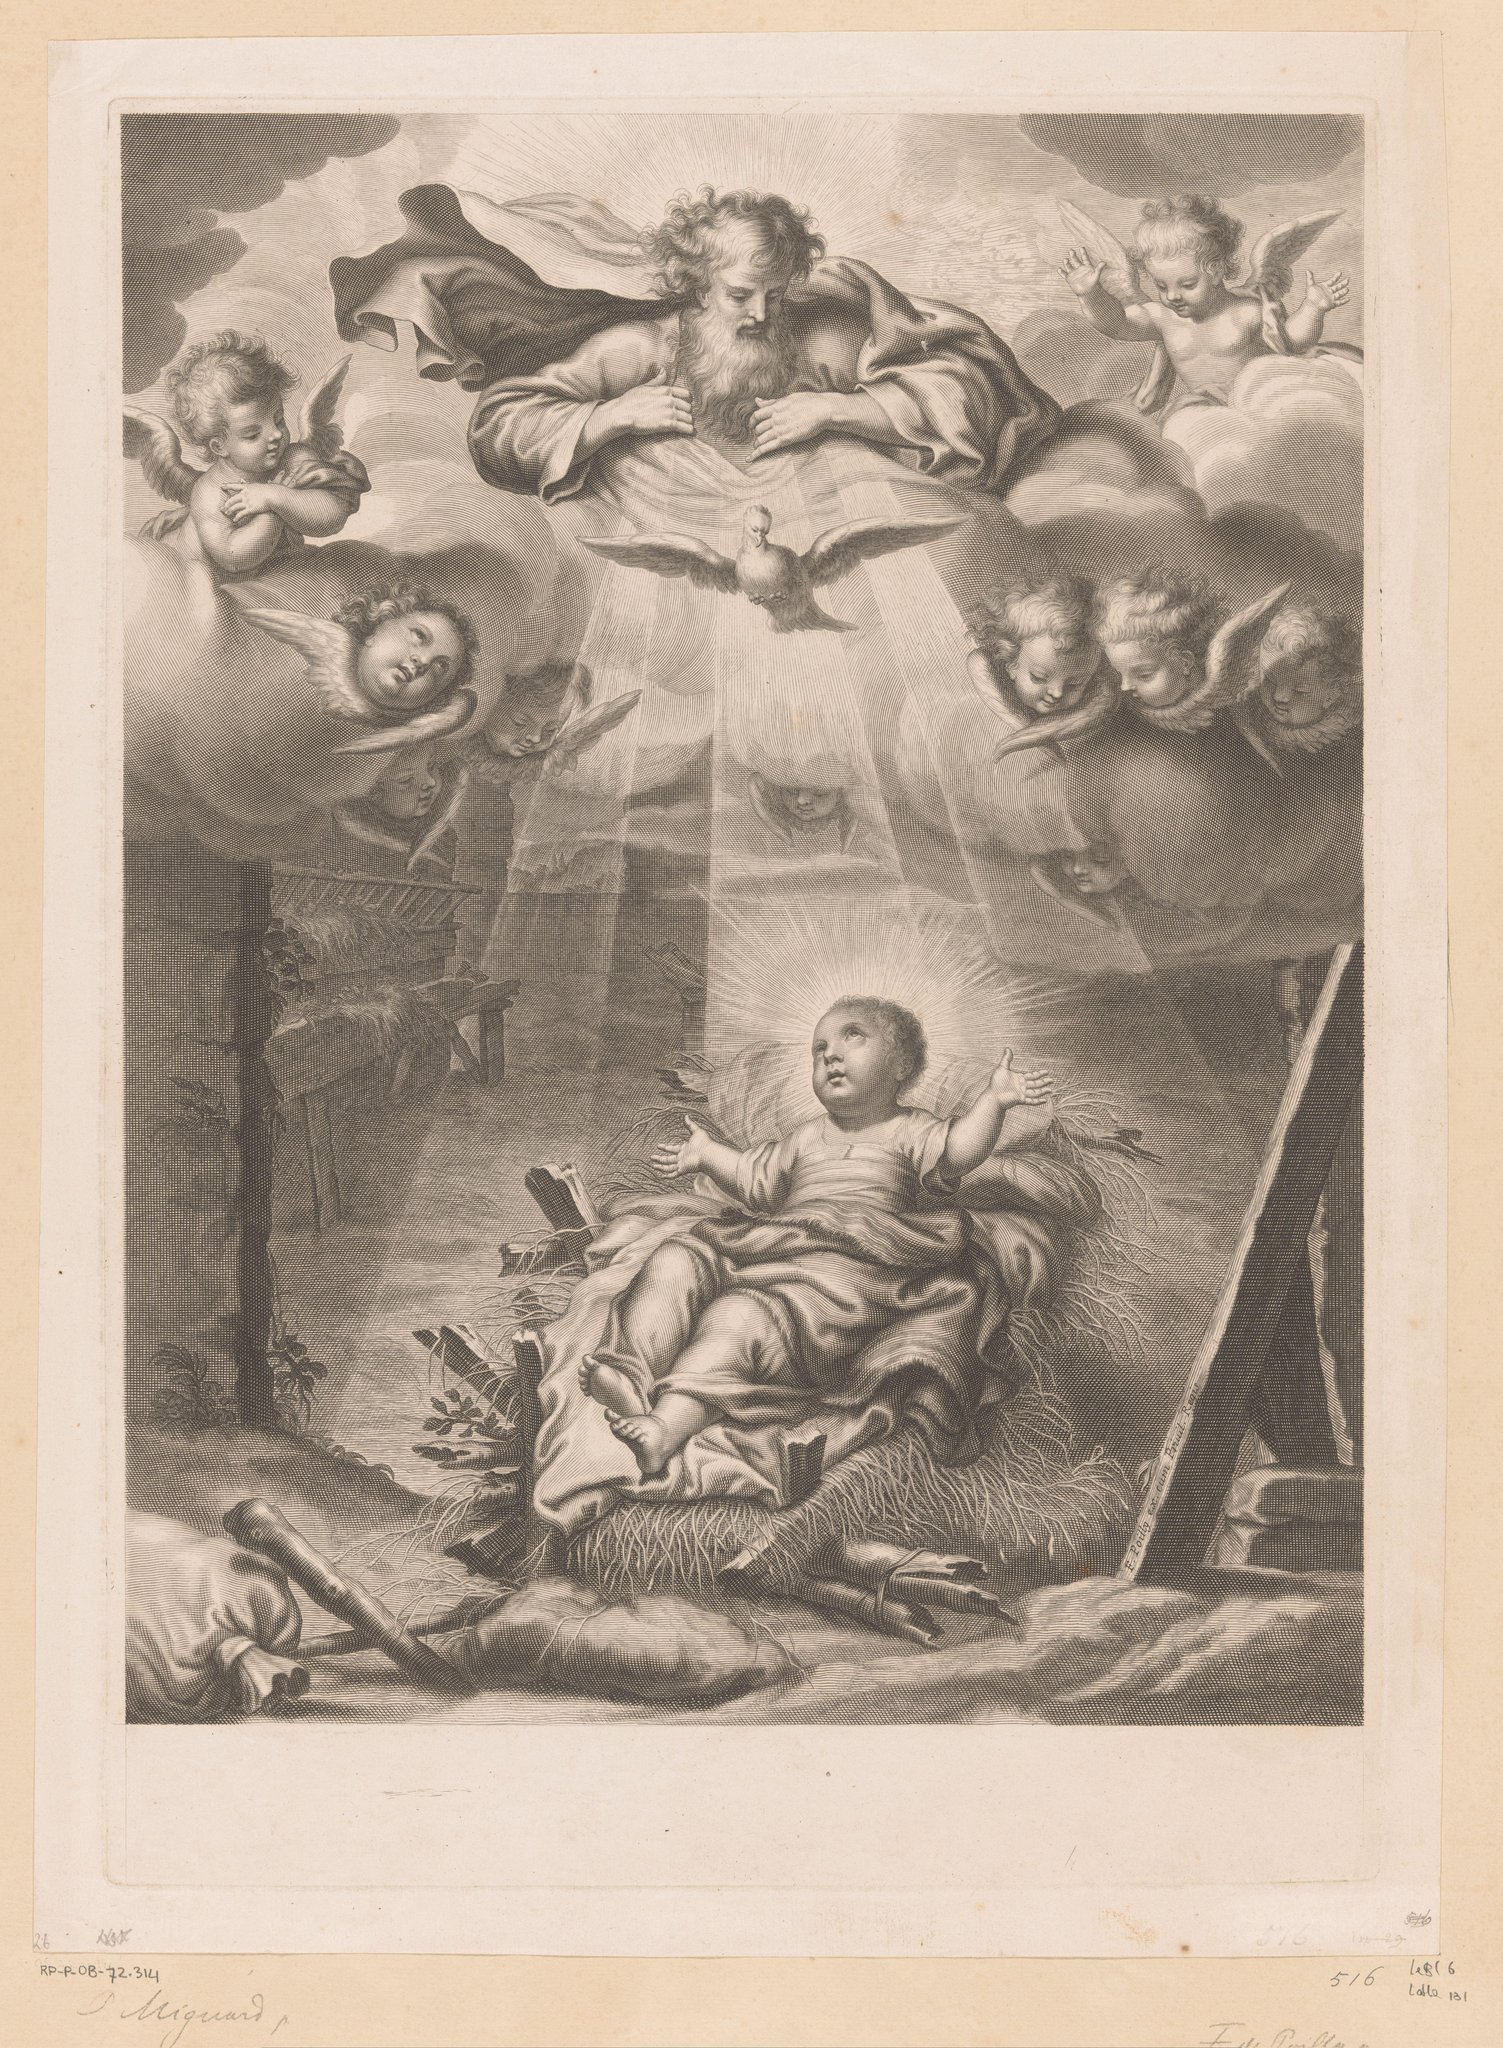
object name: print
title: Christus in de kribbe met boven hem God de Vader en de Heilige Geest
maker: françois de poilly (i)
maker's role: print maker, publisher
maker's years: 1622-1693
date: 1632-1693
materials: paper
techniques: engraving, etching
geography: france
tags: cherubs, i.e. children's heads with wings, the holy trinity, 'trinitas coelestis'; father, son and holy ghost ~ christian religion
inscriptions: collector's mark: Lugt 240